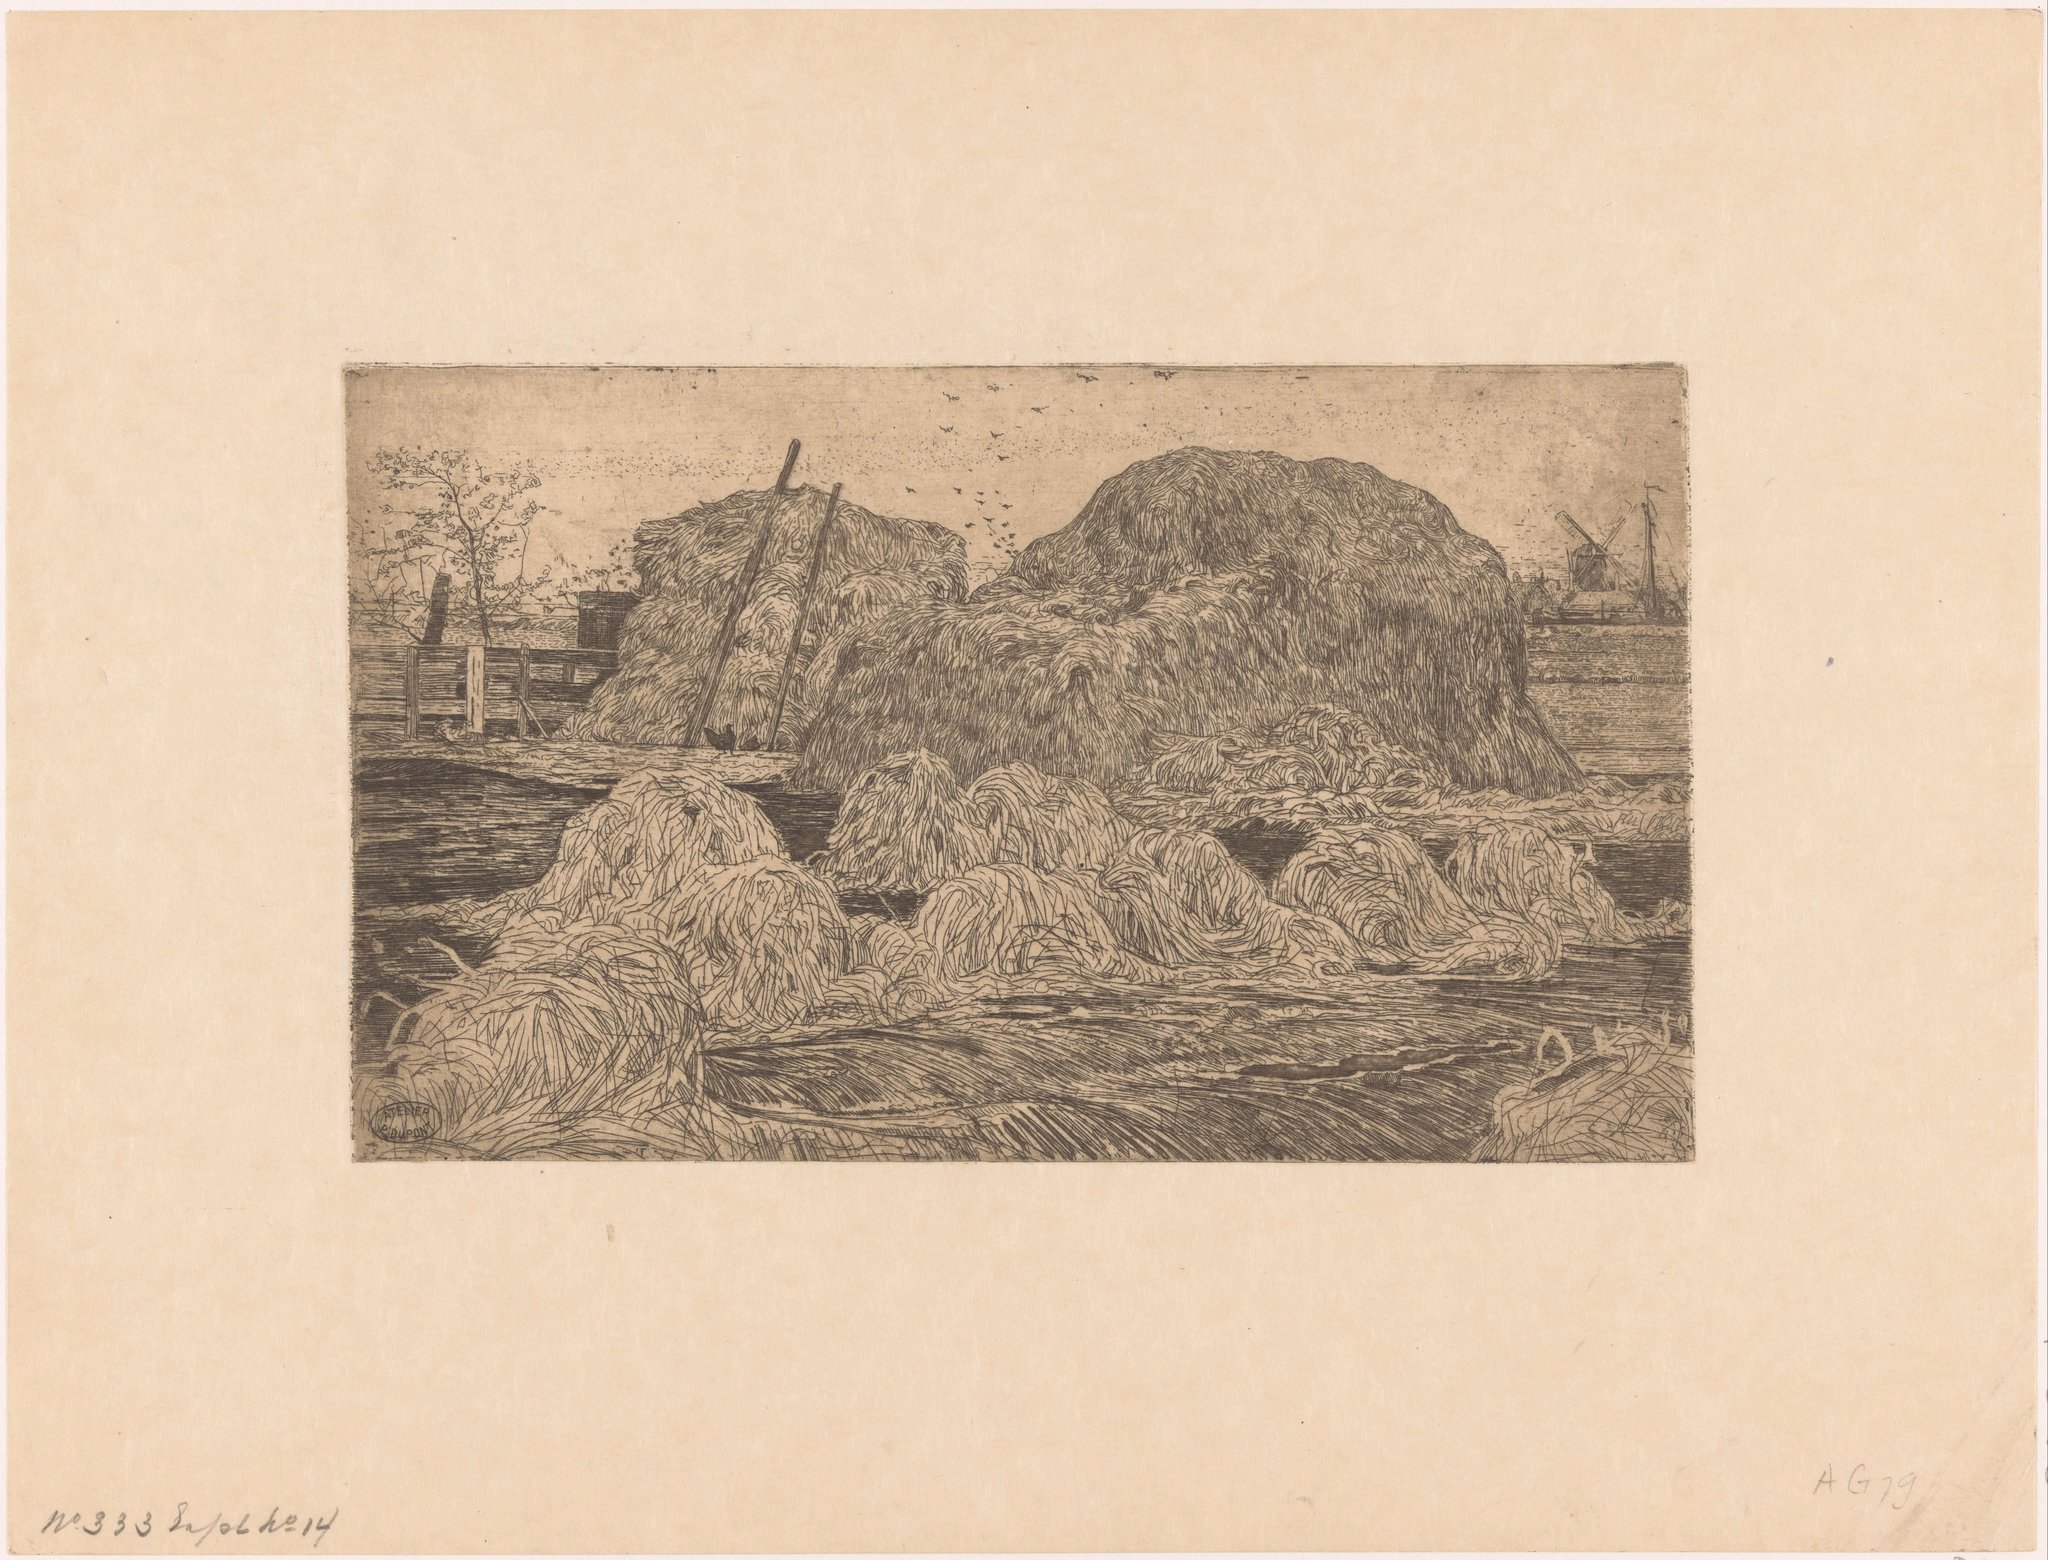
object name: print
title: Hooibergen op een akker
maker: pieter dupont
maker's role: draughtsman, print maker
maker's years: 1870-1911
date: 1811-1895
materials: paper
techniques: intaglio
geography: amsterdam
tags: hay-stack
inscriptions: workshop stamp: ‘ATELIER P. DUPONT’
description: Rechts op de achtergrond een molen en een zeilschip.